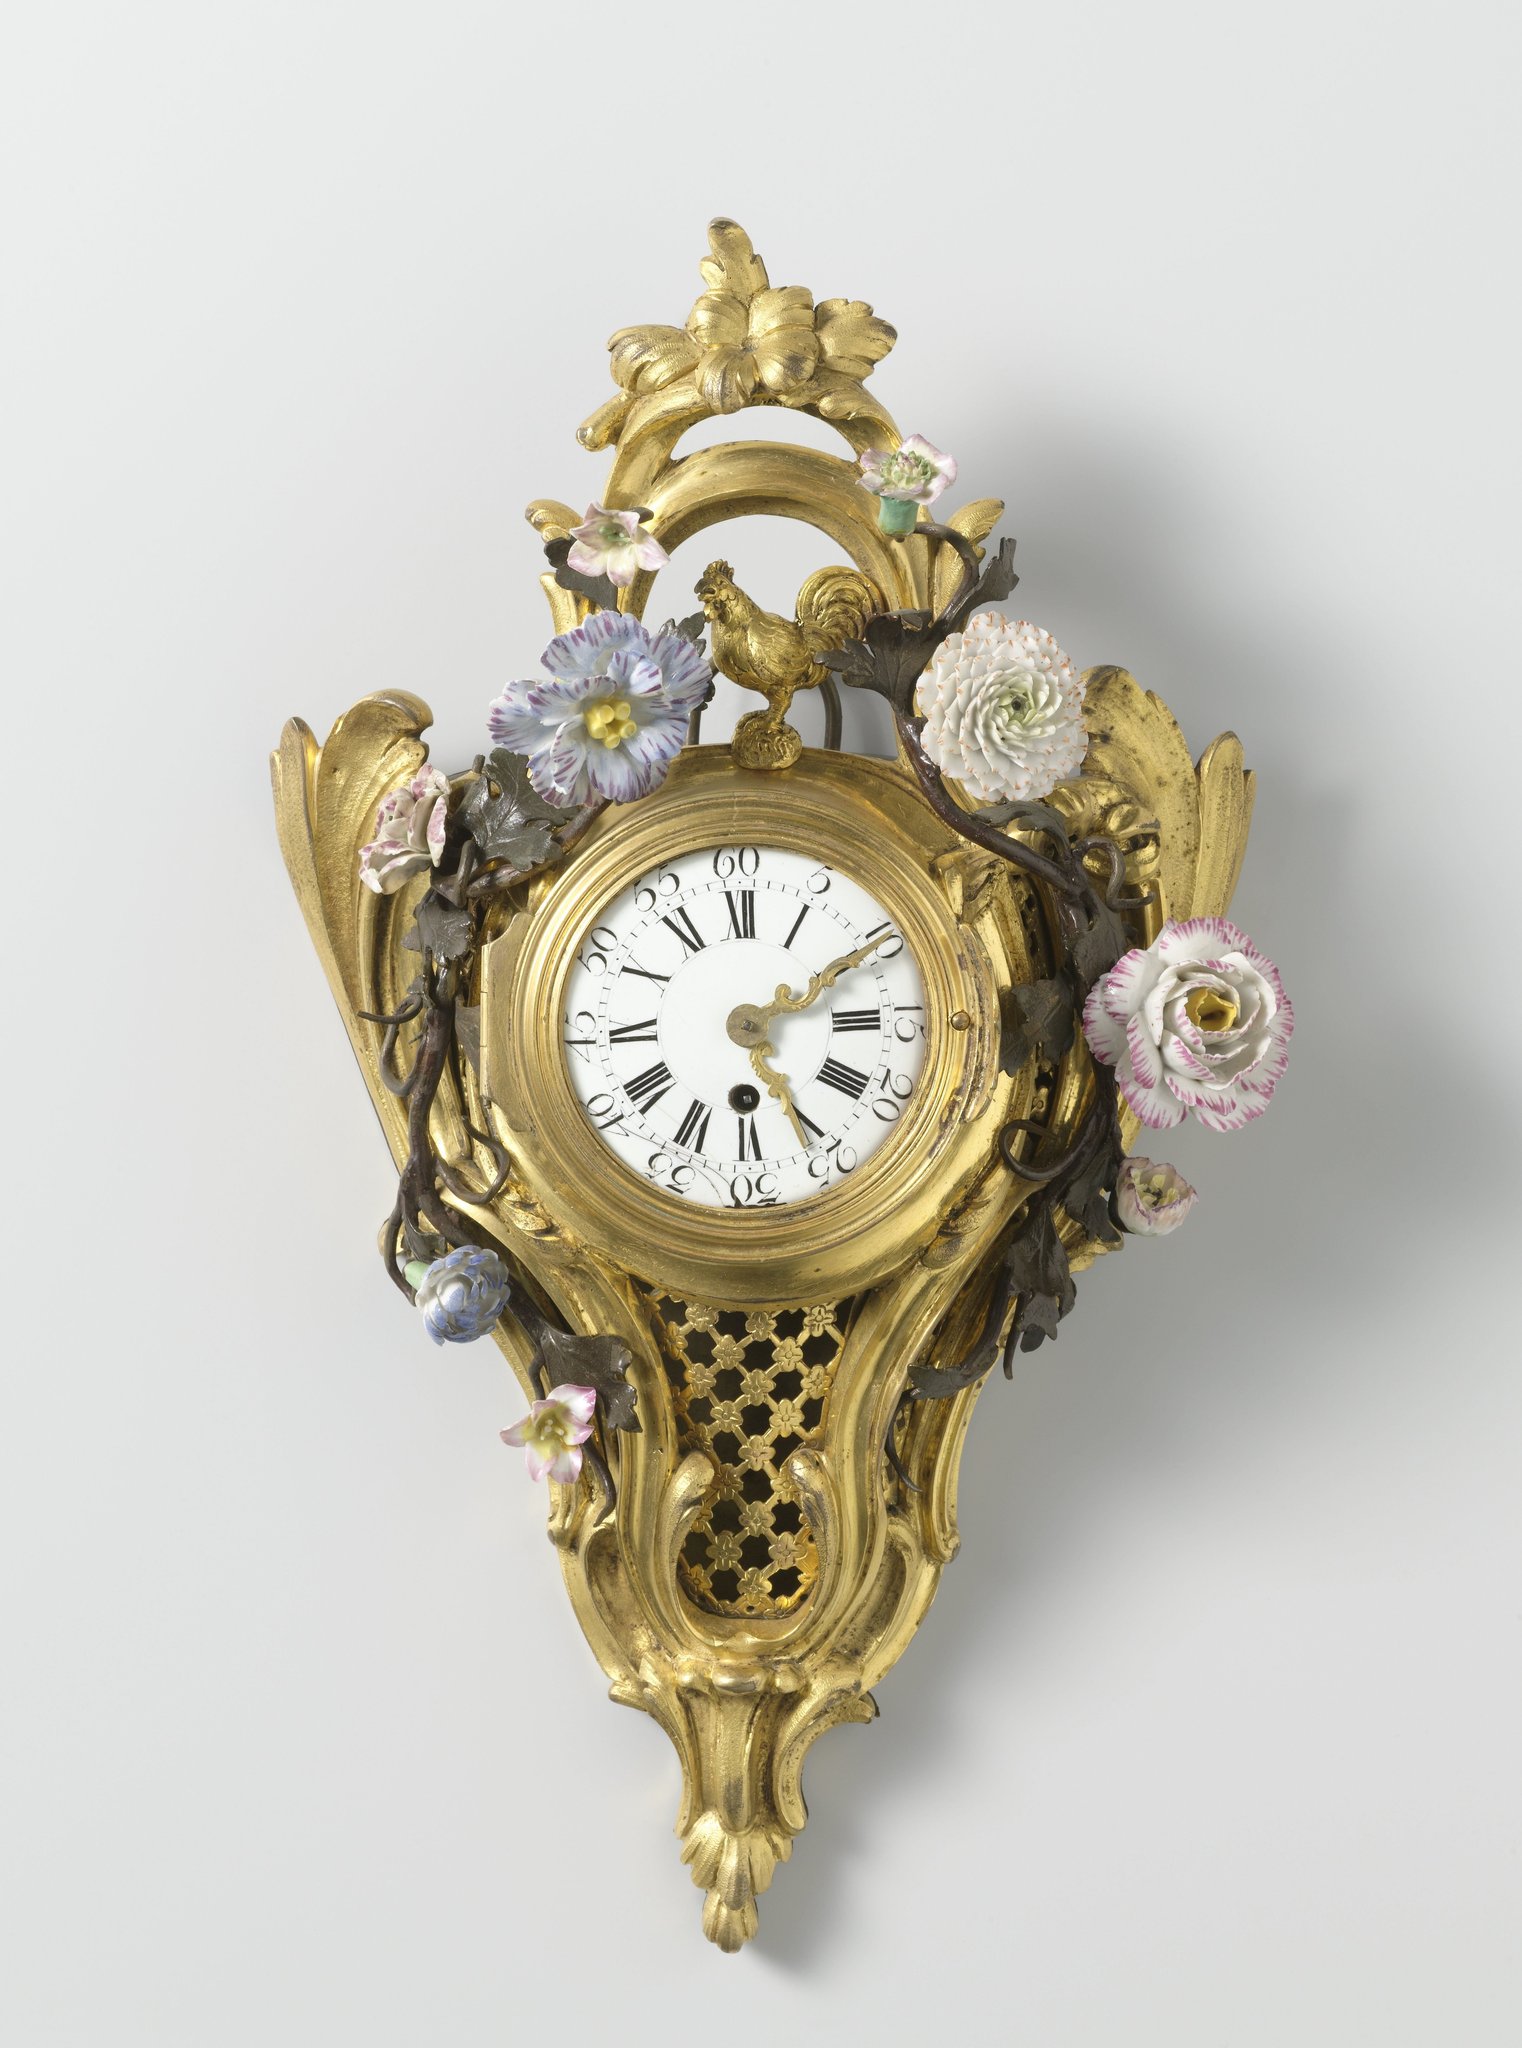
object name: furniture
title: Kartelklok van verguld brons met ronde wijzerplaat versierd met rocailles met met metalen beschilderde bladtakken met bloemen van porselein.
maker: Anonymous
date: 1750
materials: bronze, metal, porcelain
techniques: gilding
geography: france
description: Kartelklok van verguld brons. De ronde wijzerplaat is gevat in een verguld bronzen montuur, versierd met rocaillemotieven en metalen beschilderde bladtakken met bloemen van porselein.